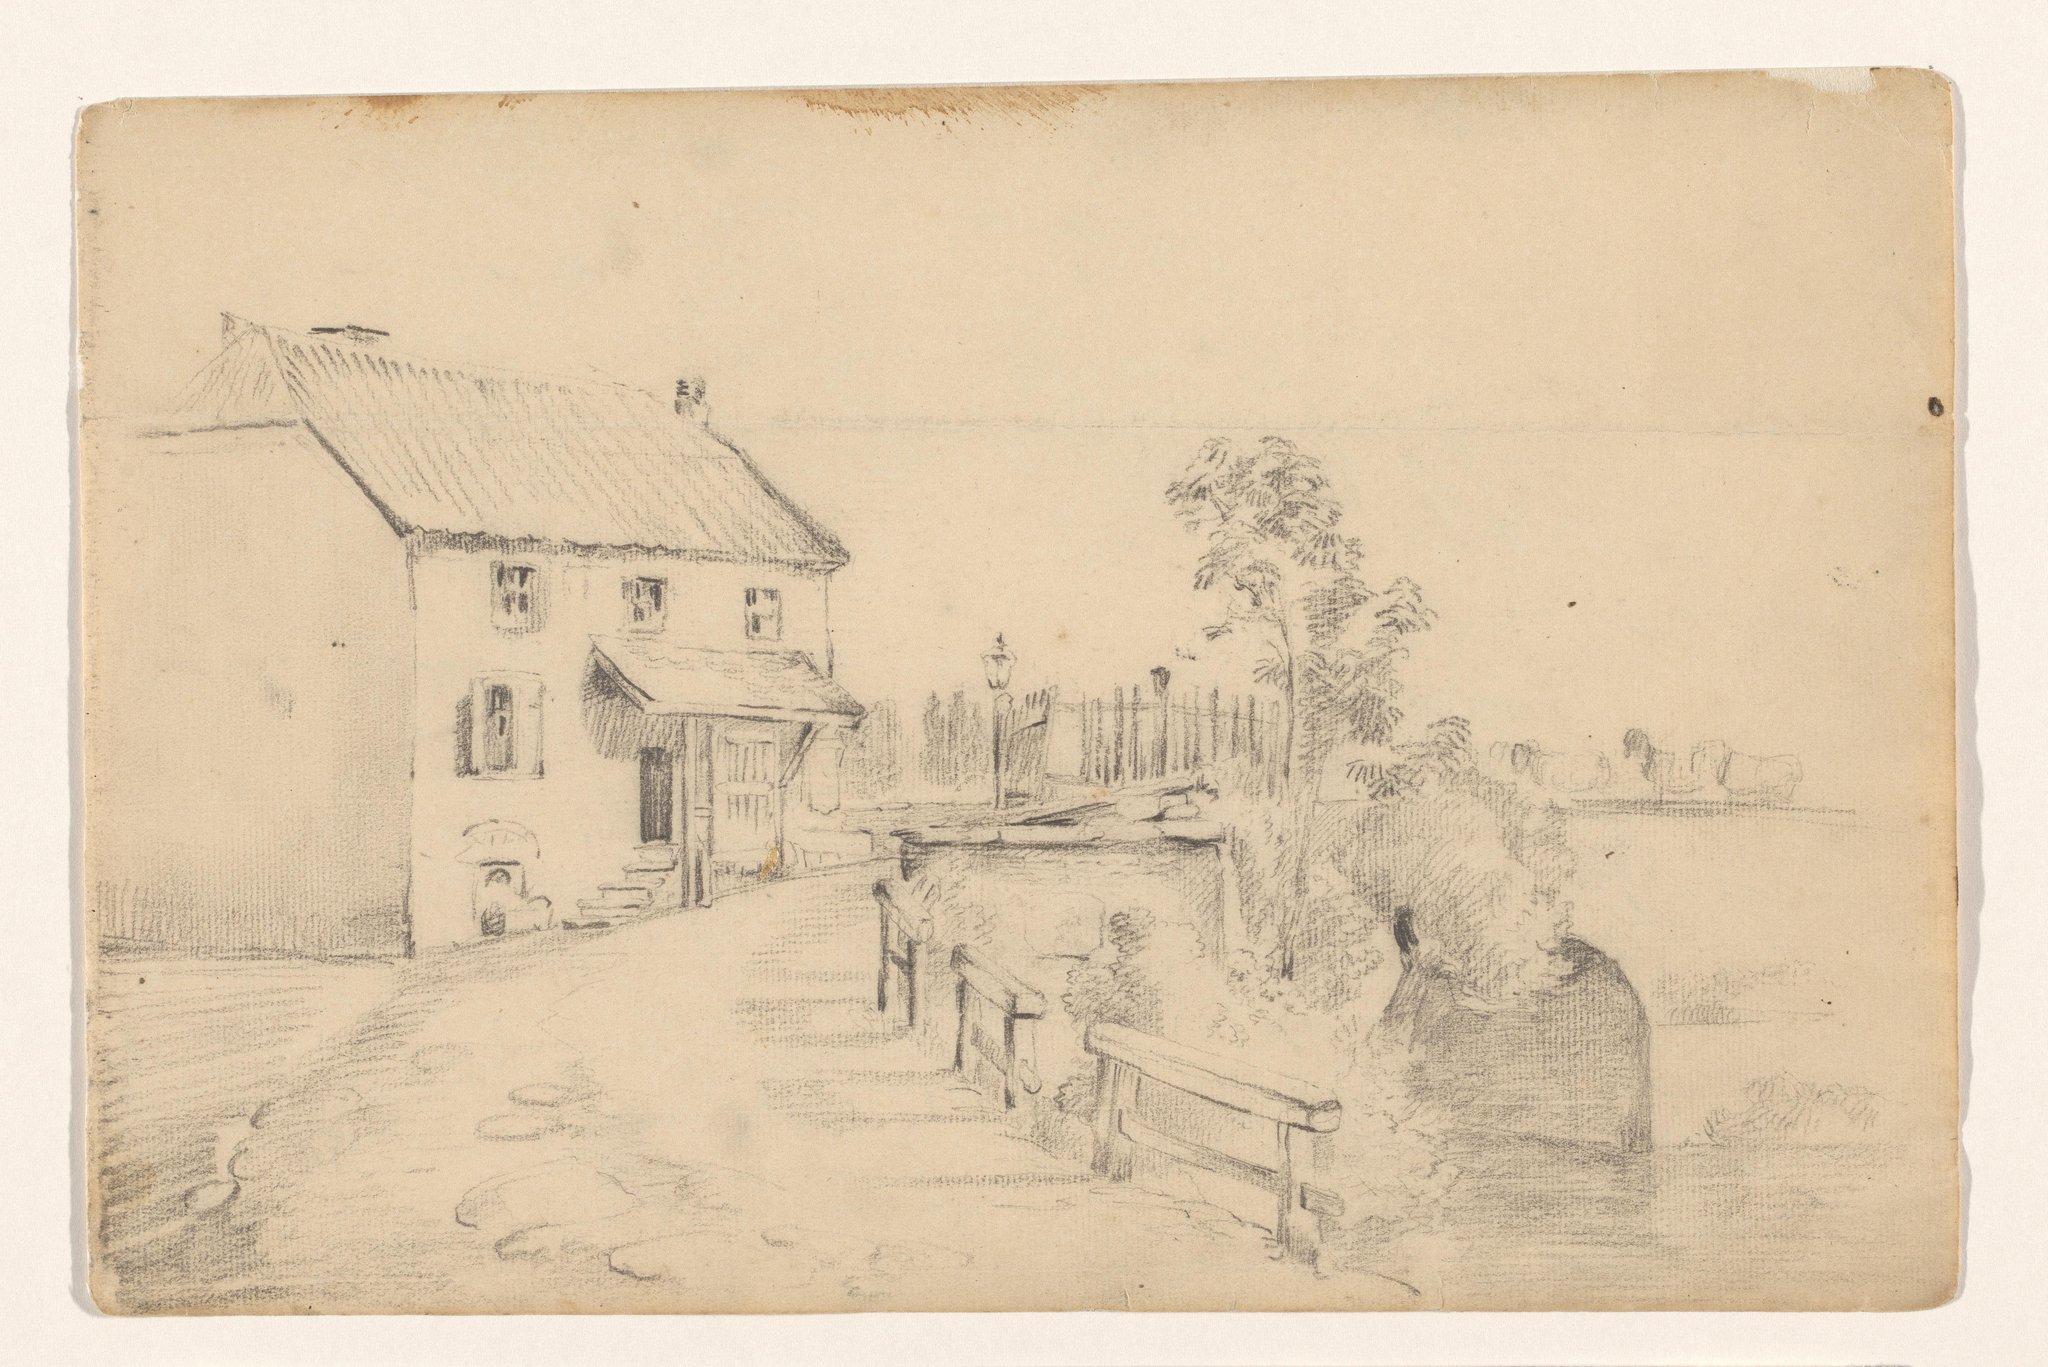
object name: drawing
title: Landschap met huis en brug over water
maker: jan bedijs tom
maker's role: draughtsman, painter, print maker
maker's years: 1813-1894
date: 1823-1894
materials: chalk, paper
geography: the hague